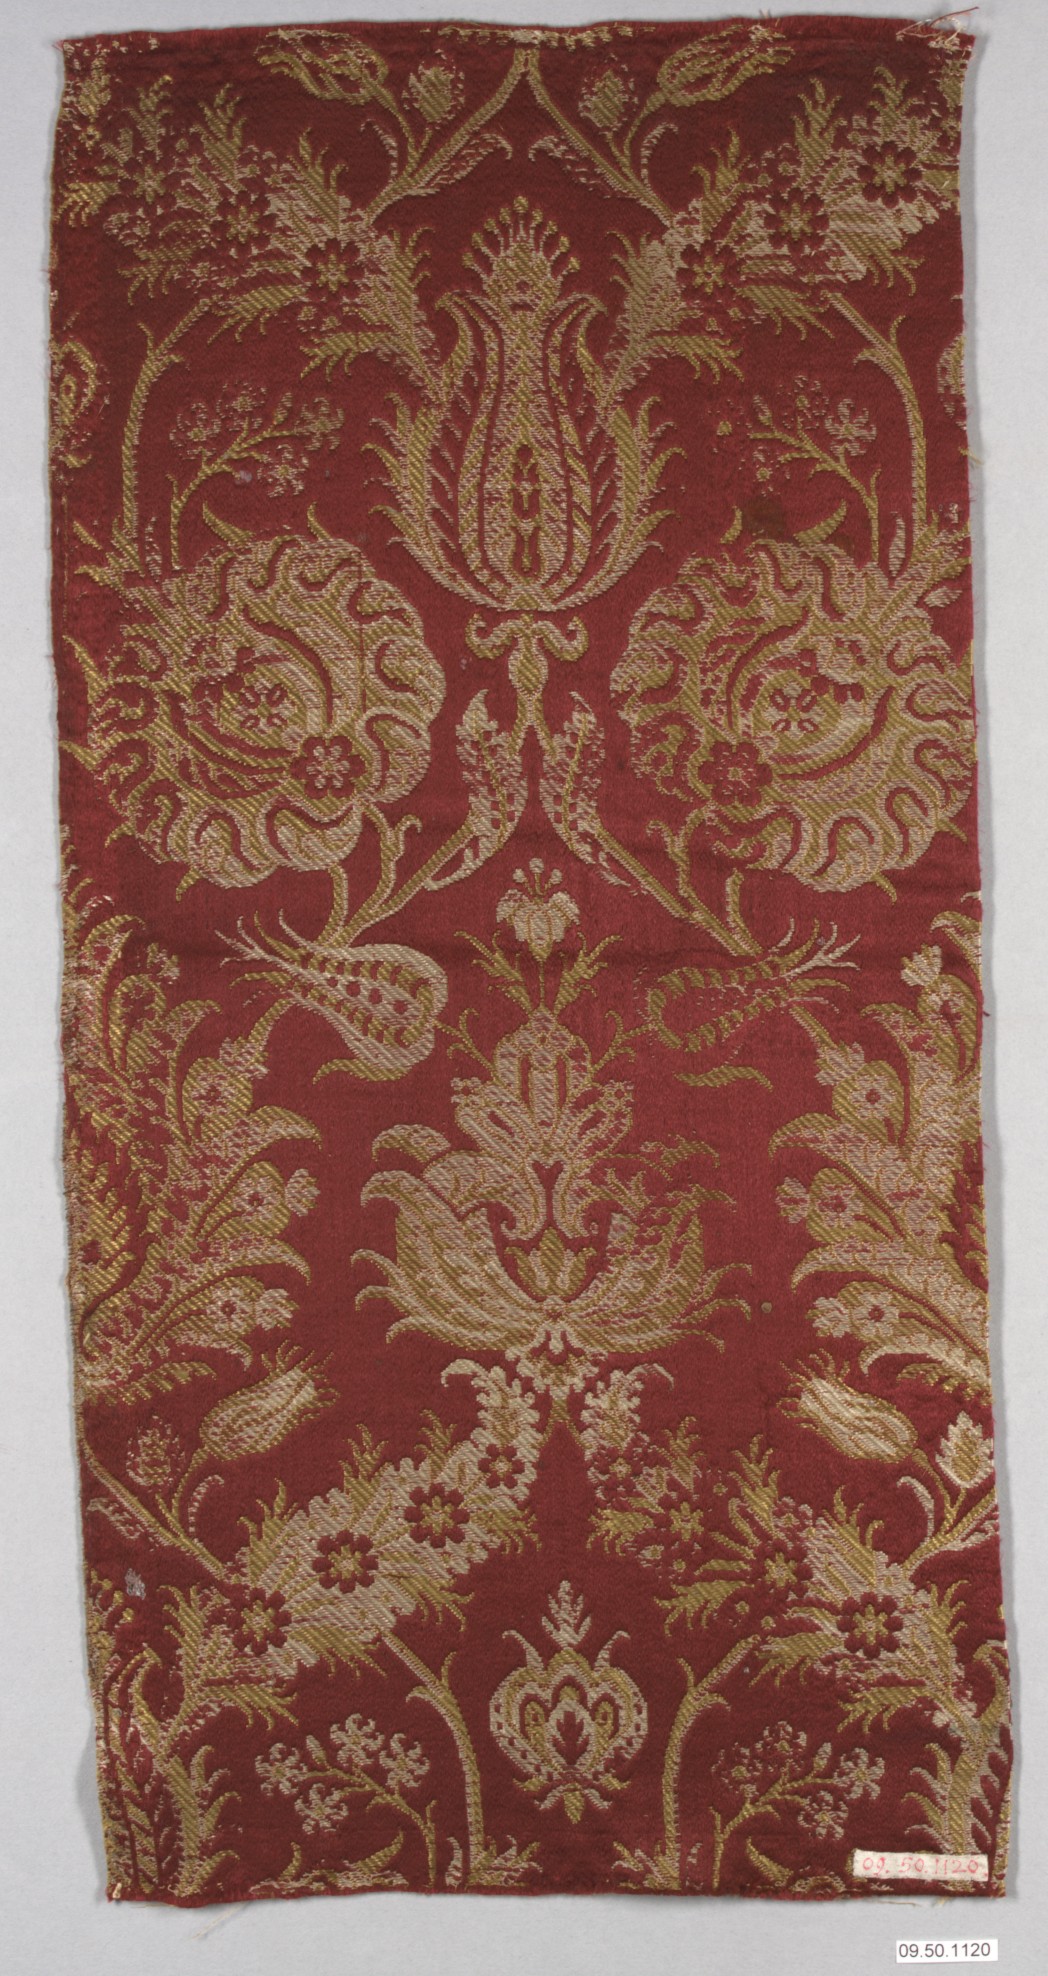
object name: textile fragment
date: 1801-1900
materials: silk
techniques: lampas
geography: turkey